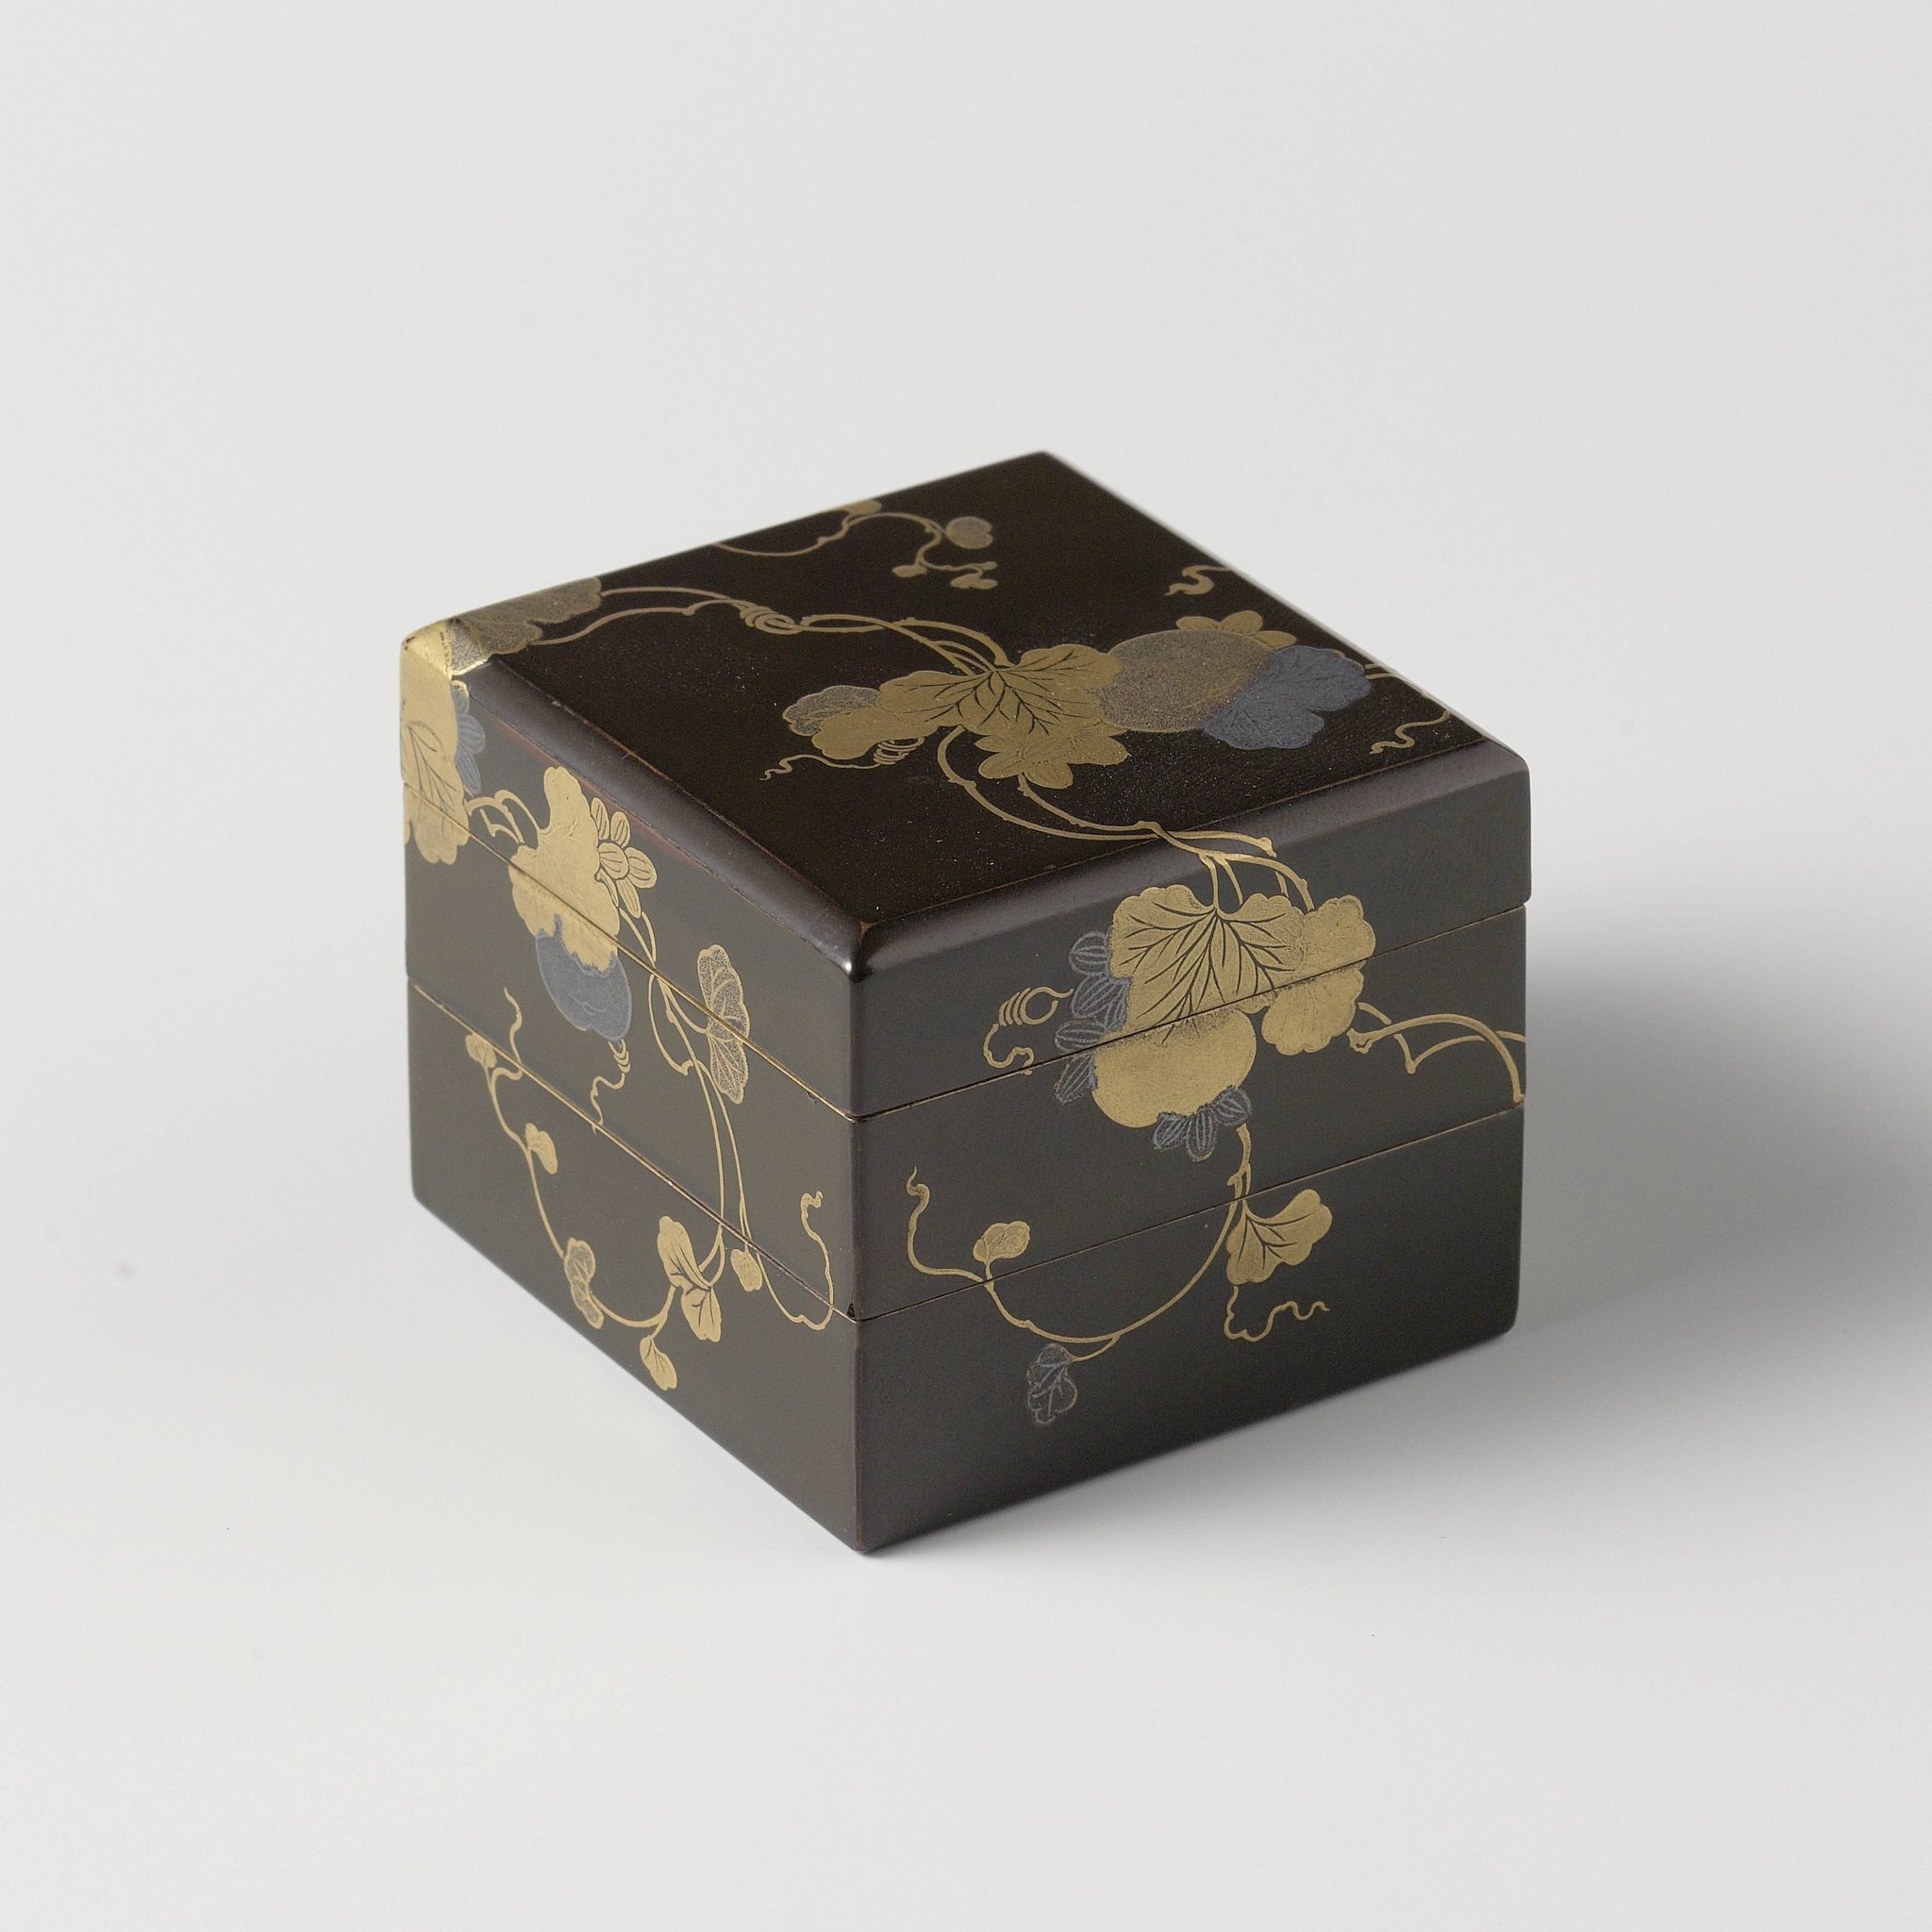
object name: box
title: Stapeldoos, zwarte lak met poempoenplanten in goud- en zilver-makie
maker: Anonymous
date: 1700-1800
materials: gold, lacquer, wood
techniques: lacquer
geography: japan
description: Stapeldoosje, bestaande uit twee bakken en een deksel. Zwarte lak met over de zijden en deksel zich uitspreidend een decor van pompoenplanten in goud- en zilver-makie. De binnenzijde nashiji.